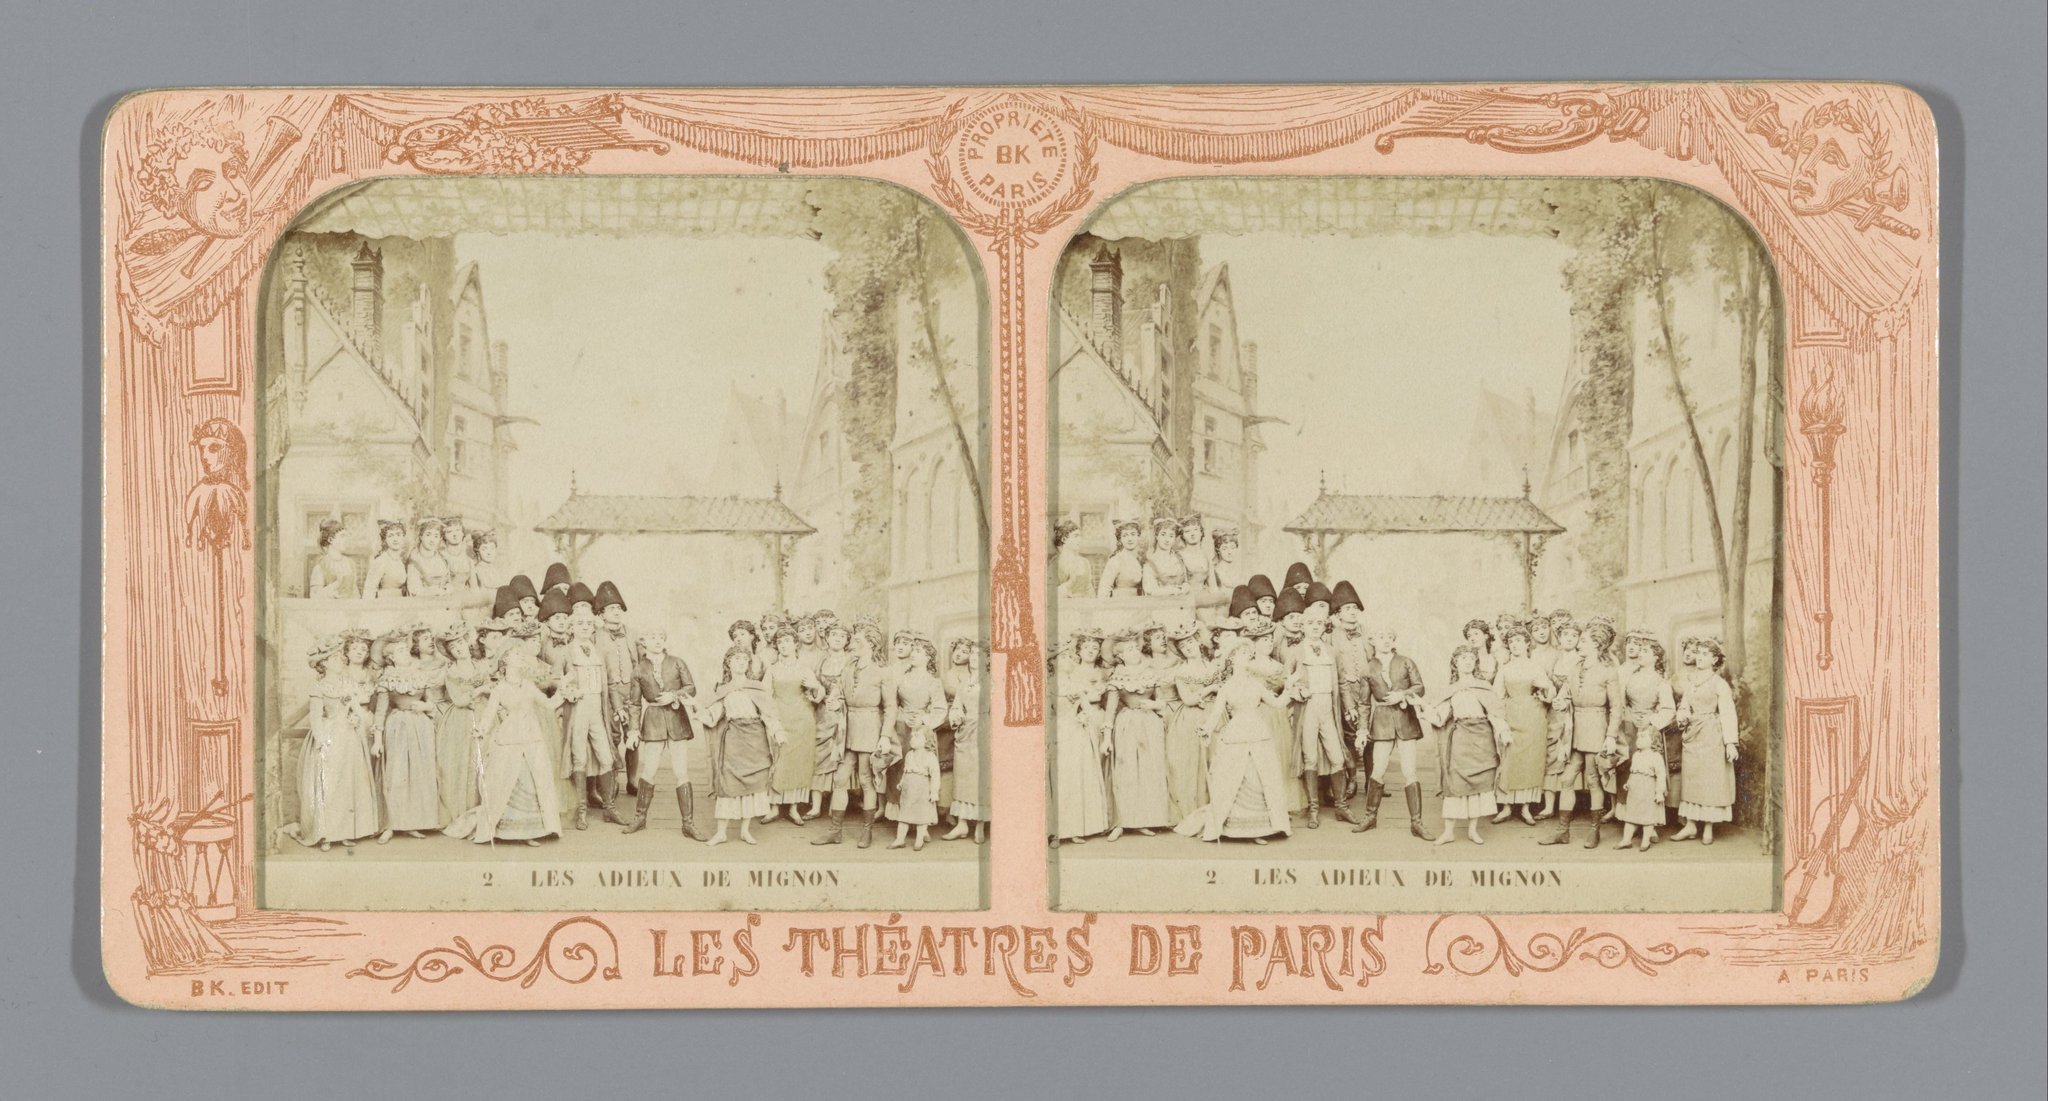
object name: stereograph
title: Les adieux de Mignon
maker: Anonymous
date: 1867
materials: cardboard, photographic support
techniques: albumen print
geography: paris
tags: group of actors, troupe; actors on the stage, paris